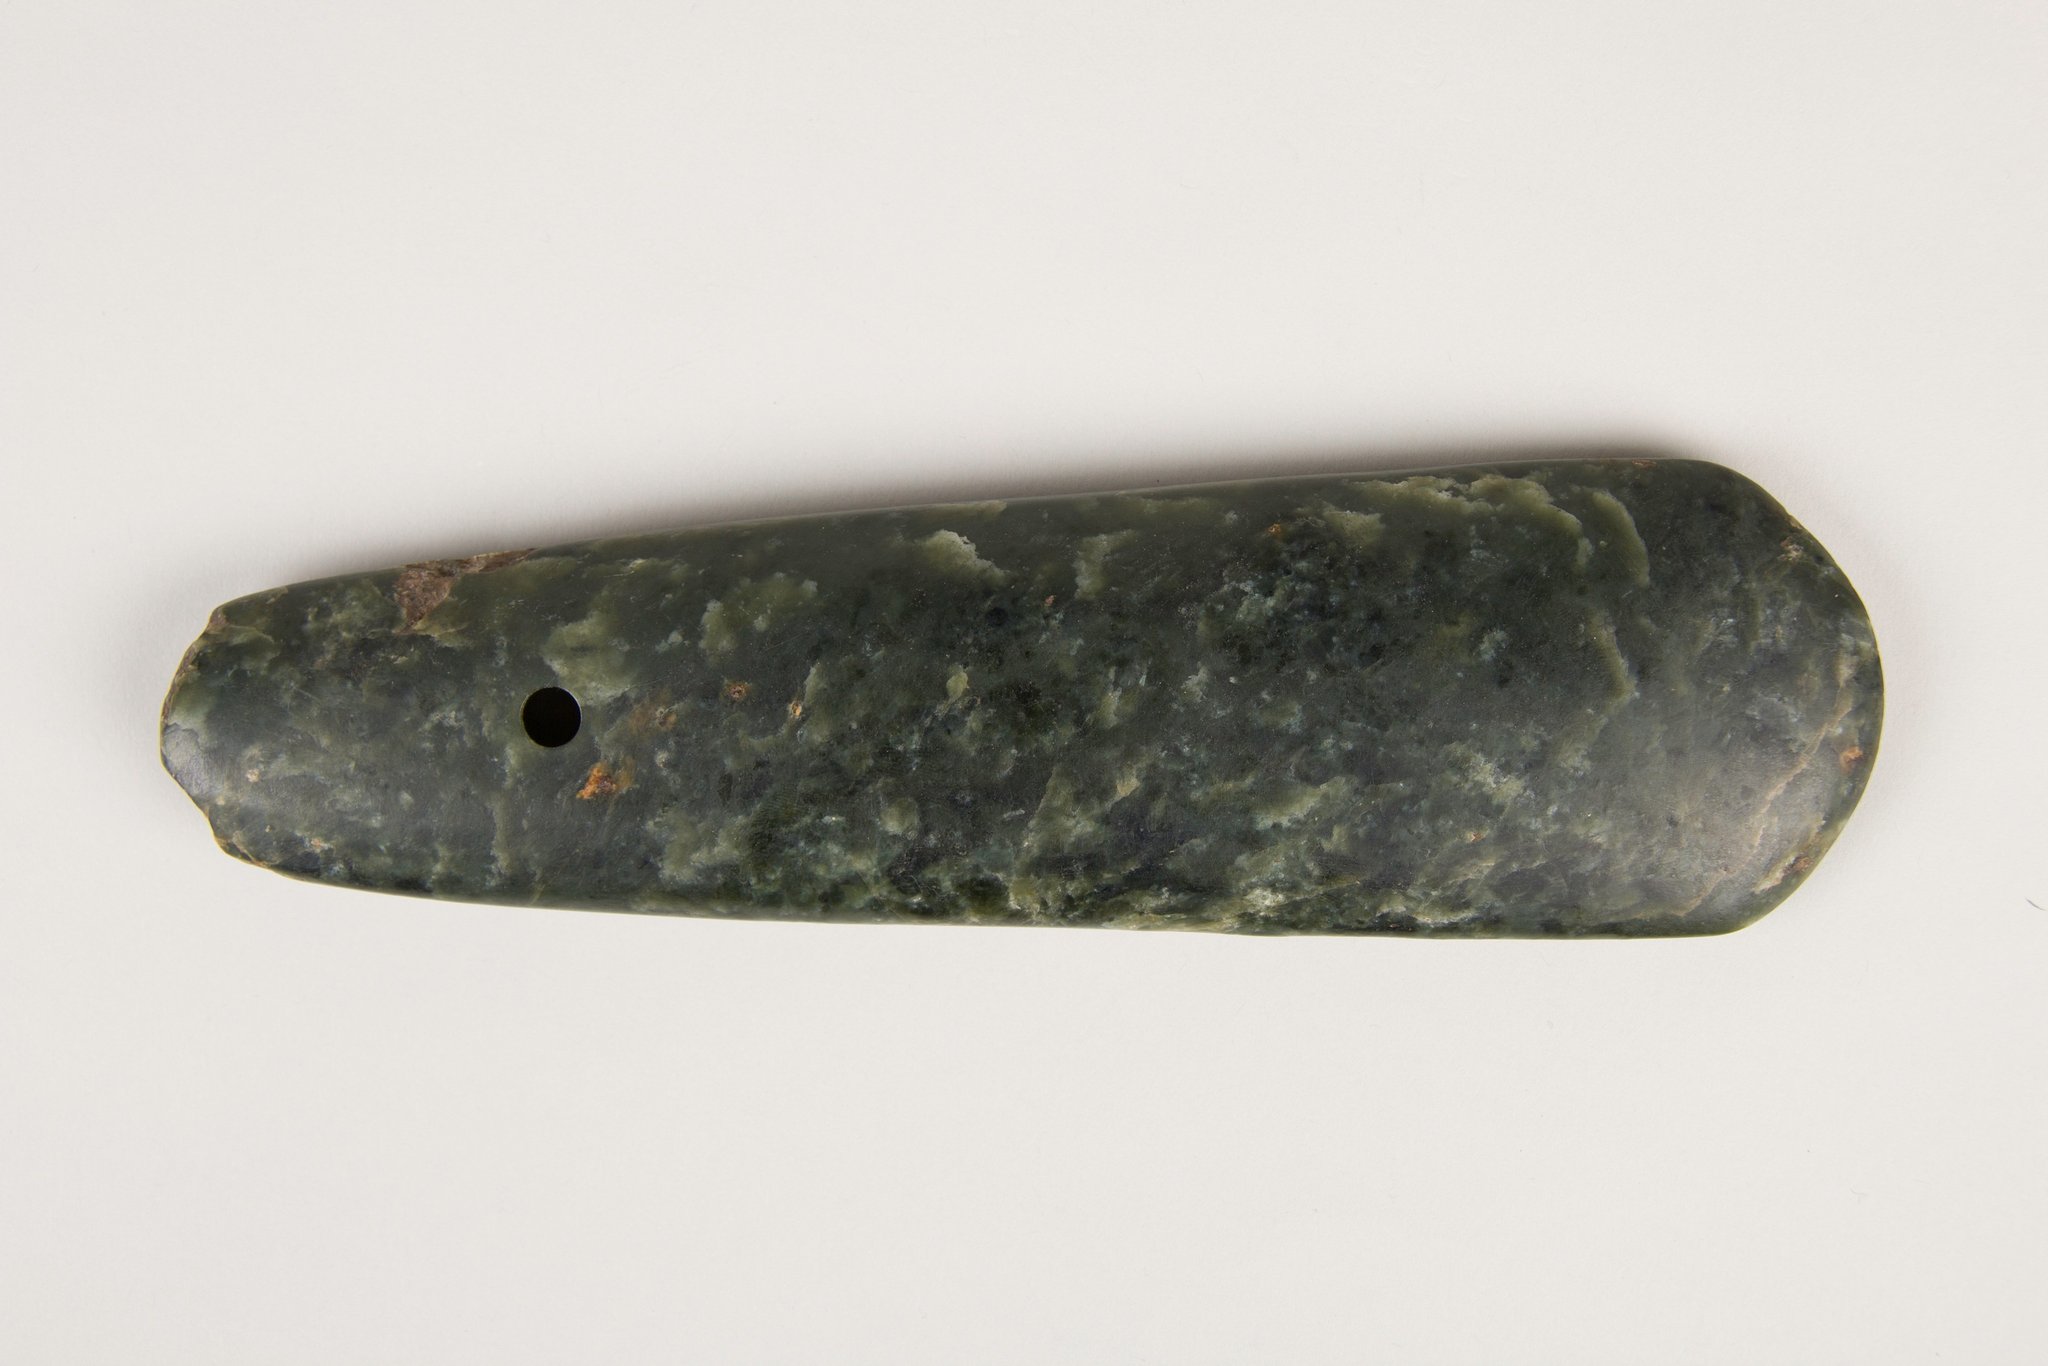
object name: axe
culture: chinese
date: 1902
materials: jade